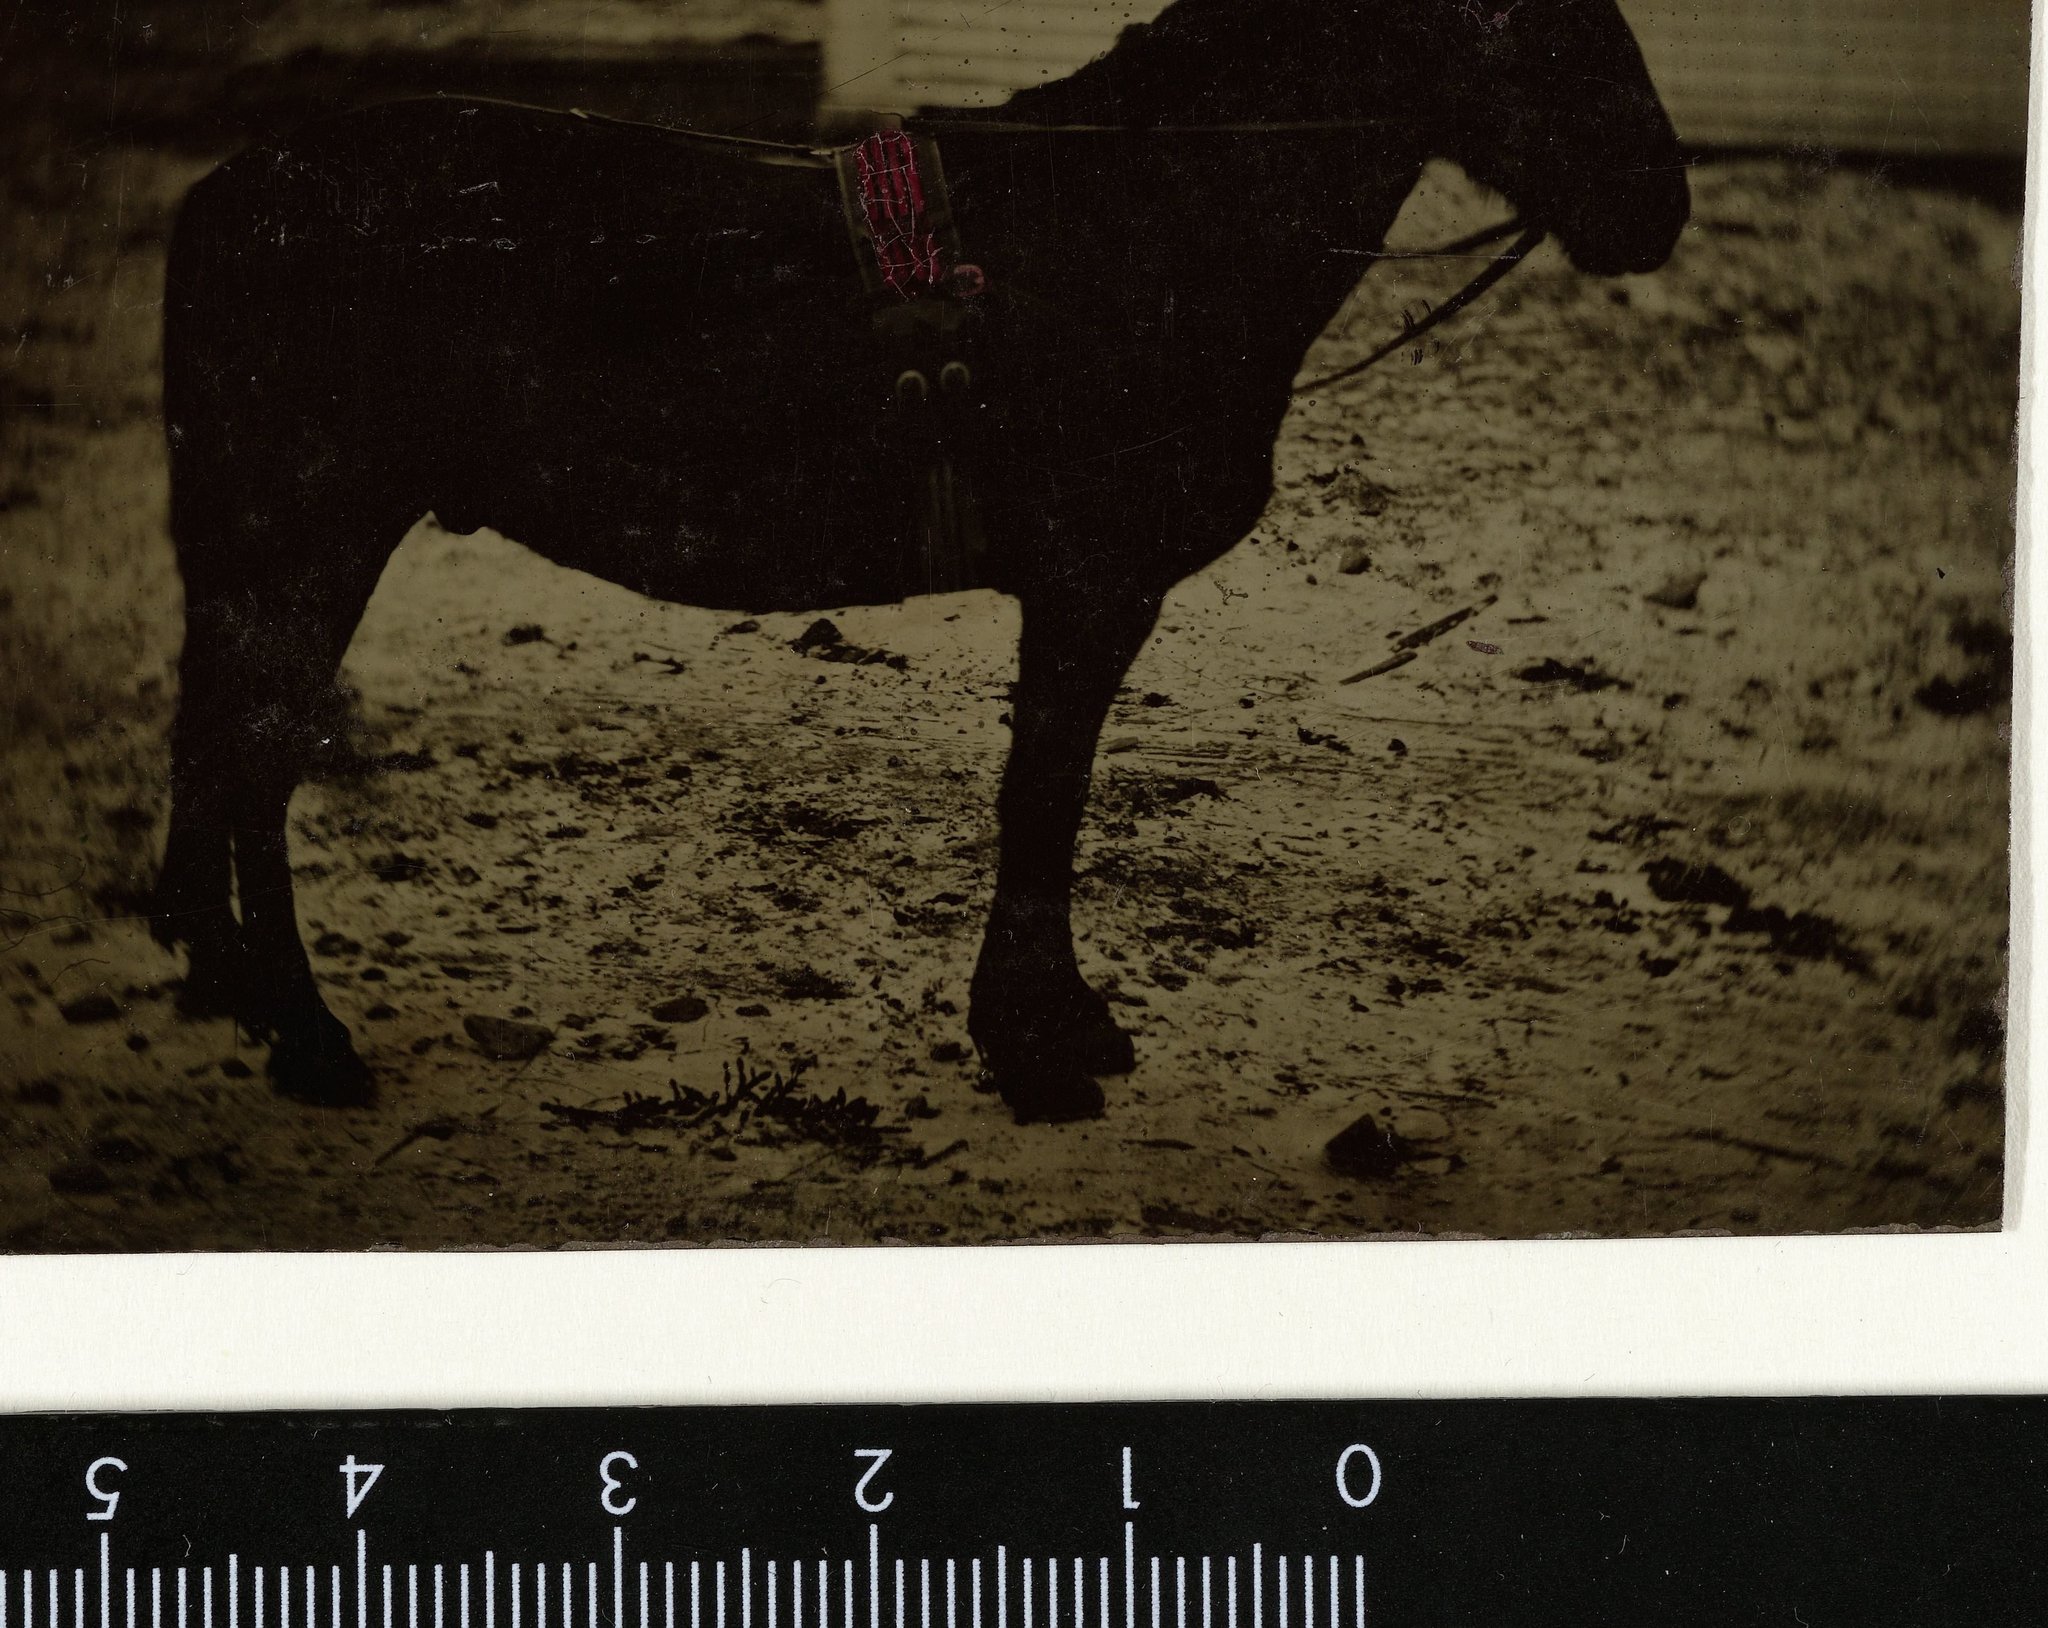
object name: photograph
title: Paard voor huizen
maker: Anonymous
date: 1870-1910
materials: metal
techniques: ferrotyping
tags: horse